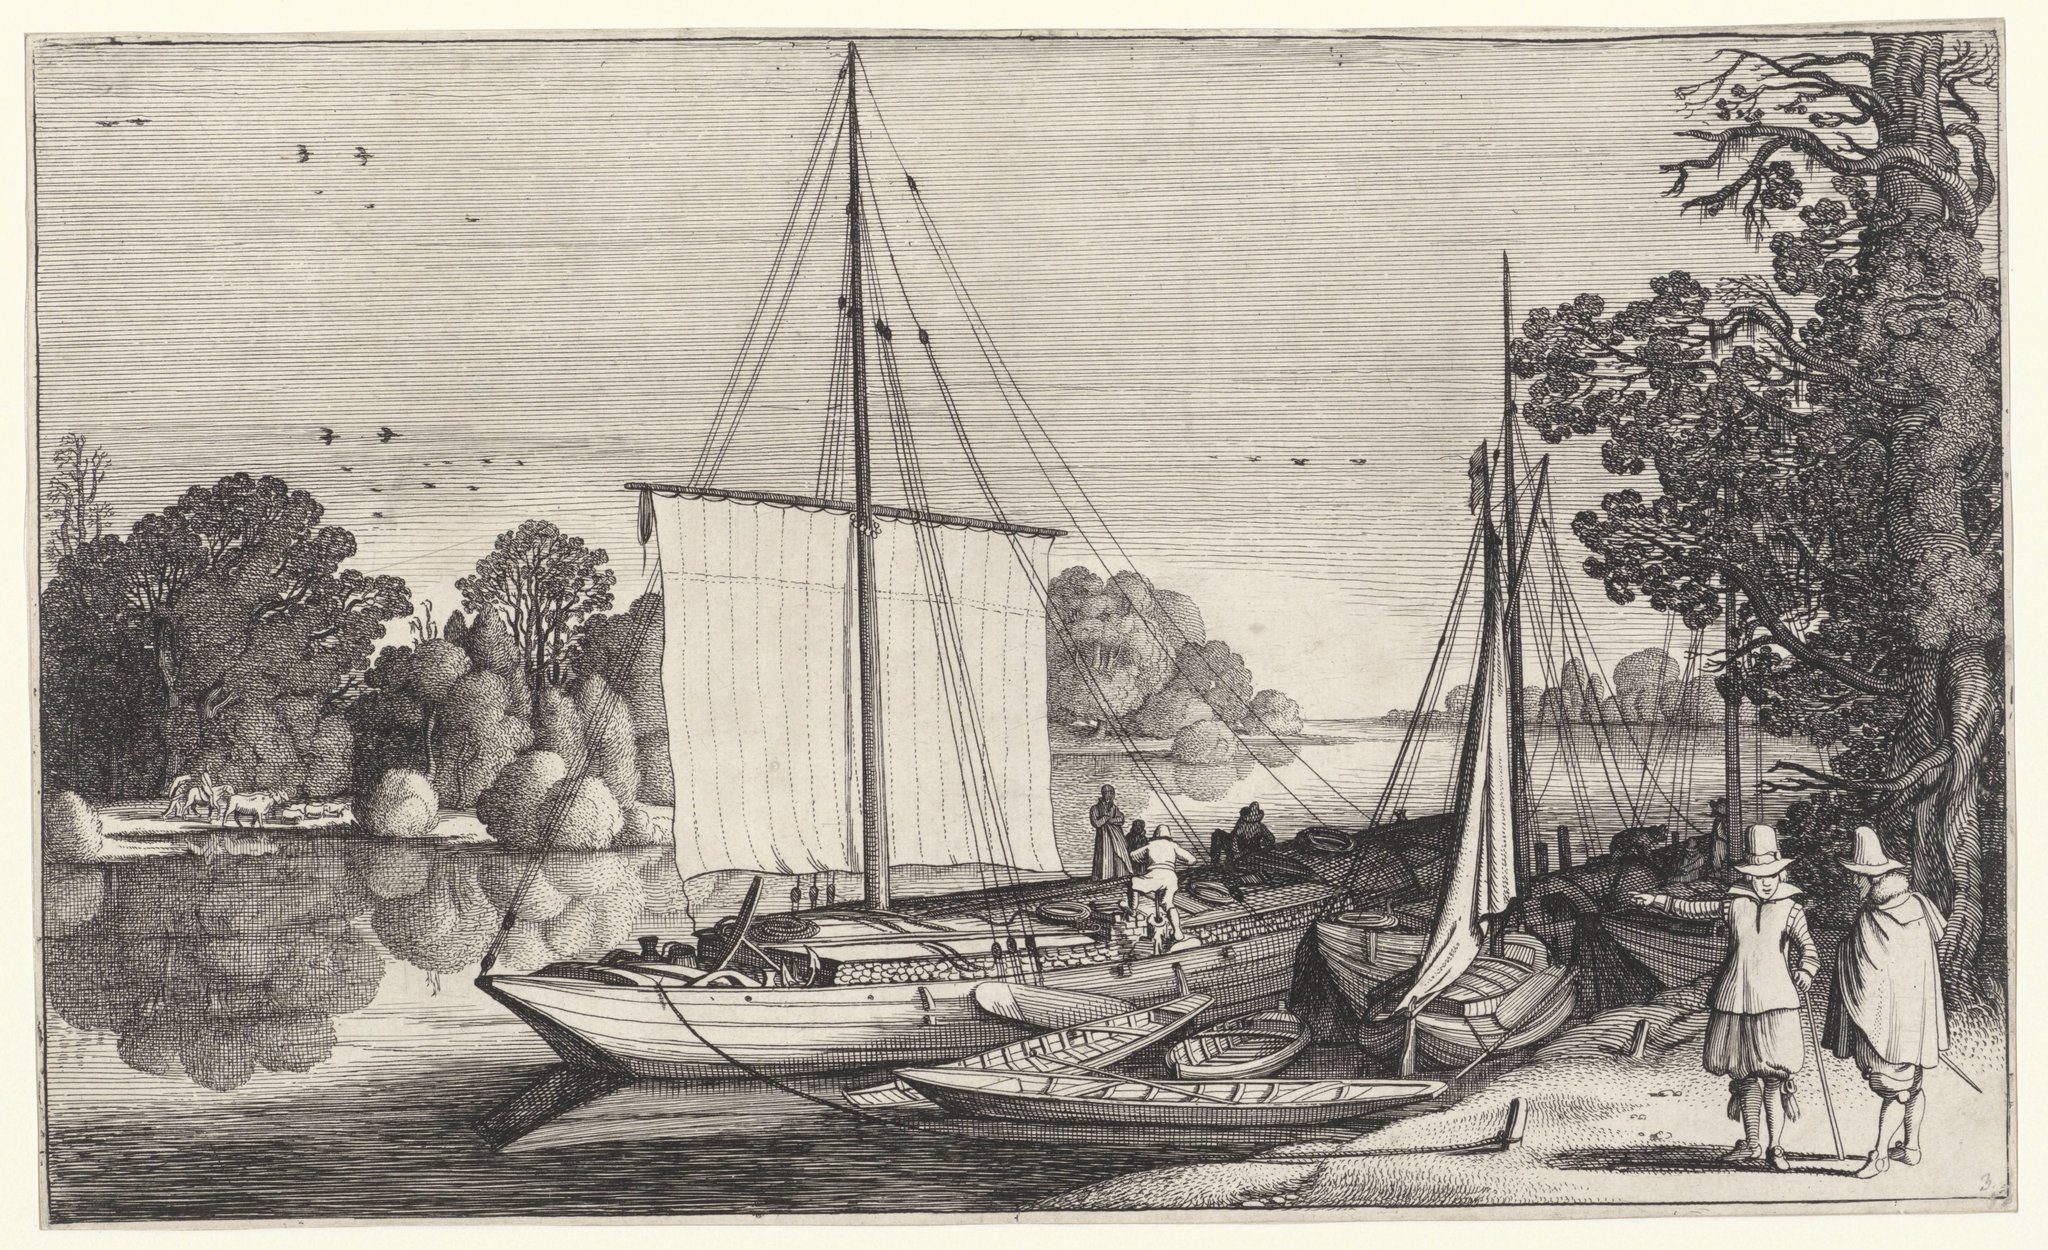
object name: print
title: Turfschepen langs een kade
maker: jan van de velde (ii)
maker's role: draughtsman, painter, print maker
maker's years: 1593-1641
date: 1603-1641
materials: paper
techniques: etching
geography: northern netherlands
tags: peat (soil type), sailing-ship, sailing-boat, river, traffic and transport (+ arrival, coming to anchor, at anchor), index finger forwards, pointing, indicating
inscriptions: collector's mark: Lugt 2228, number: ‘3’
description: Twee figuren bij turfschepen langs een kade. Derde prent van een serie van vier.